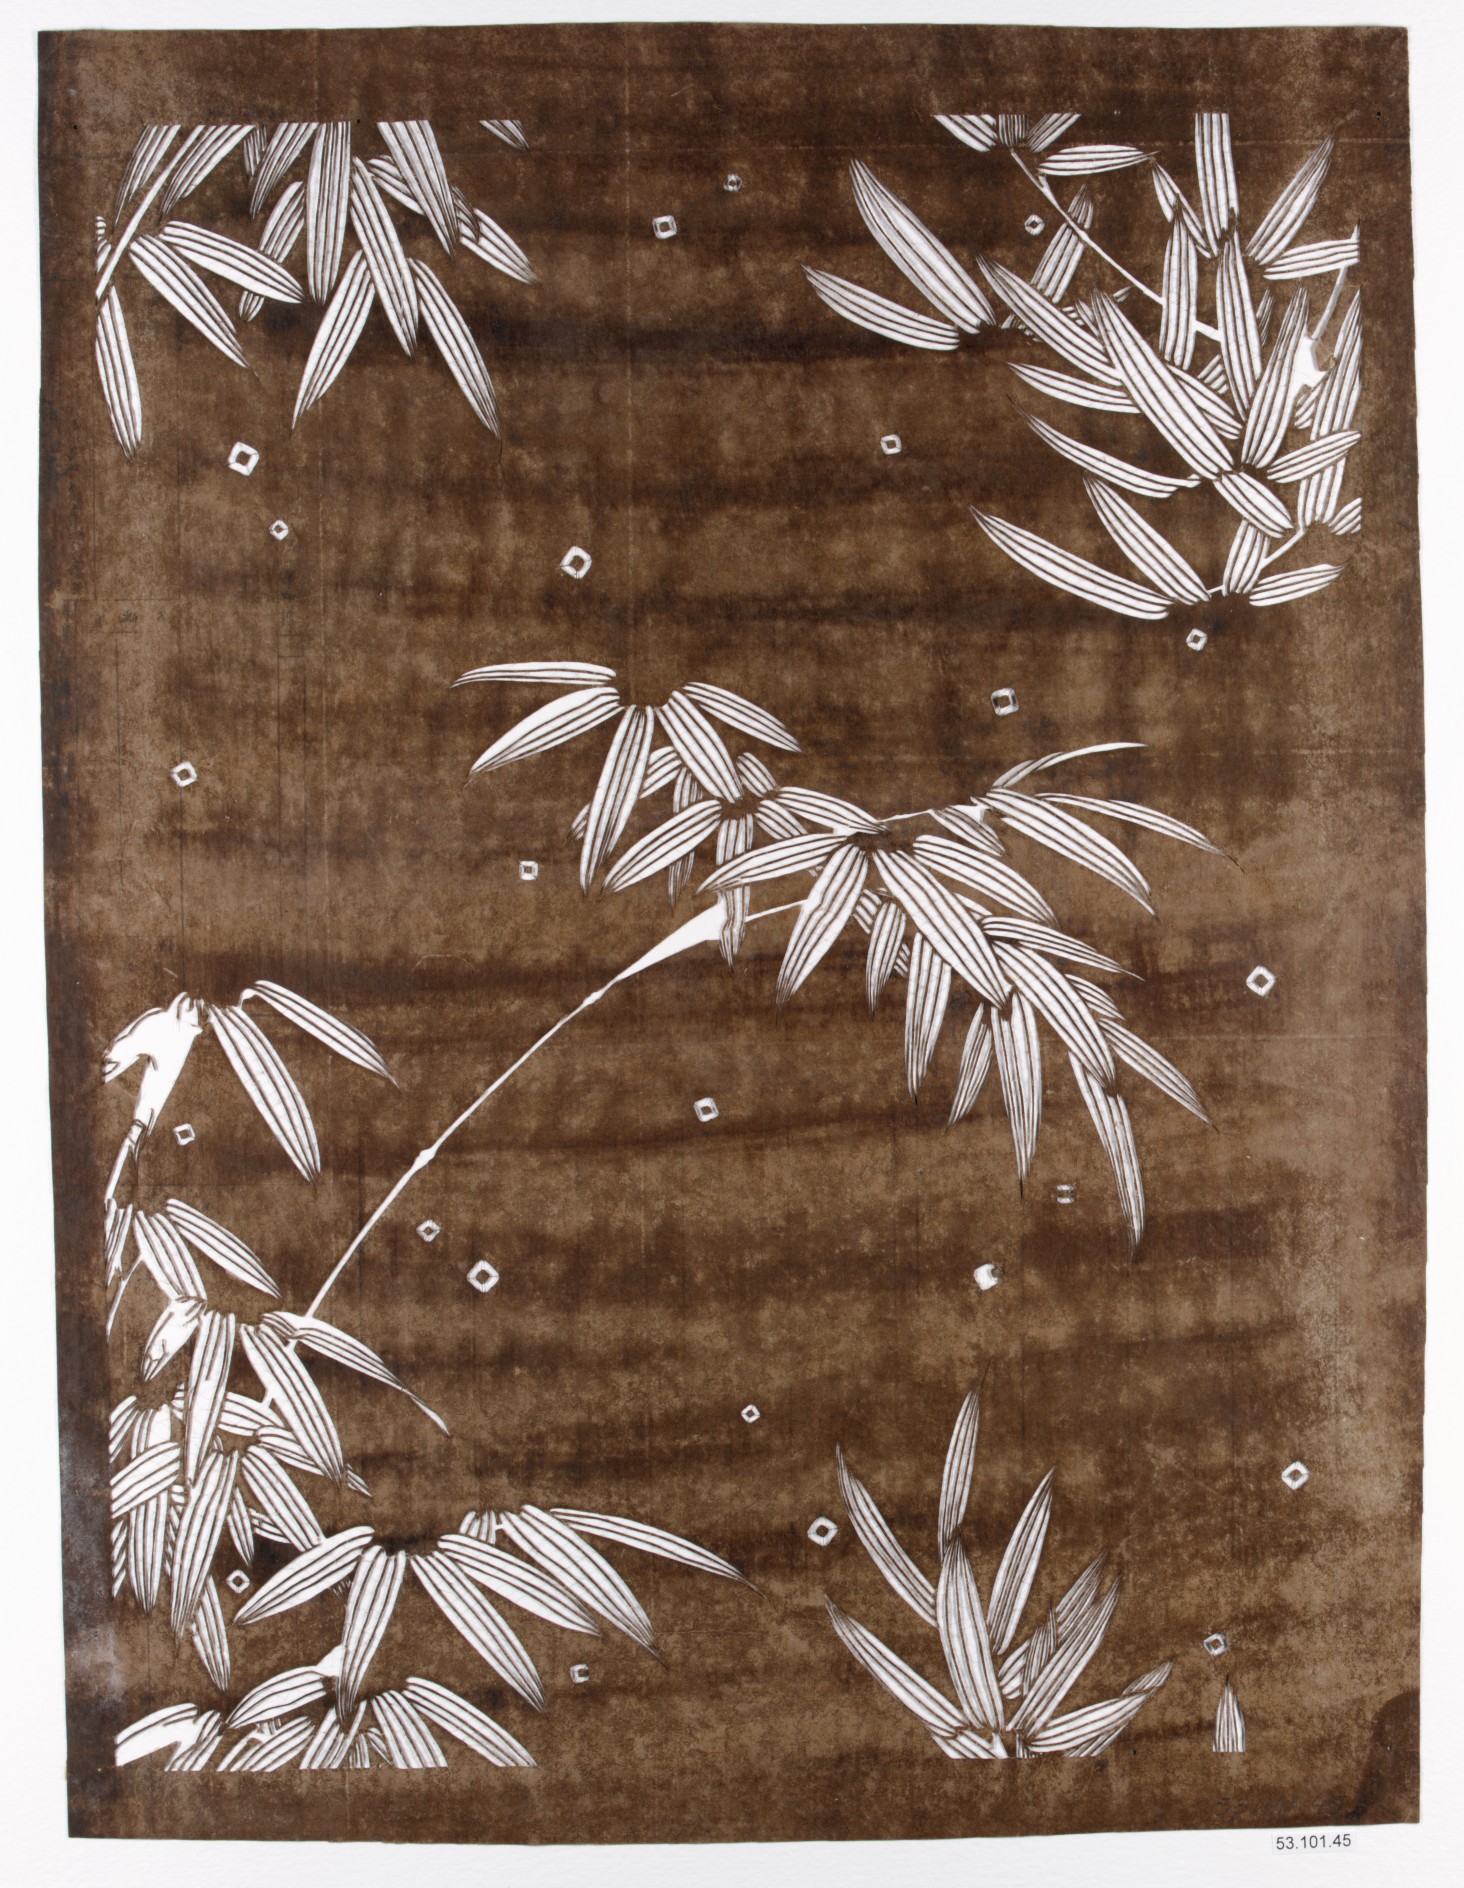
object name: stencil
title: Stencil with Bamboo and Falling Snow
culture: japanese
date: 1801-1900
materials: paper, silk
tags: bamboo